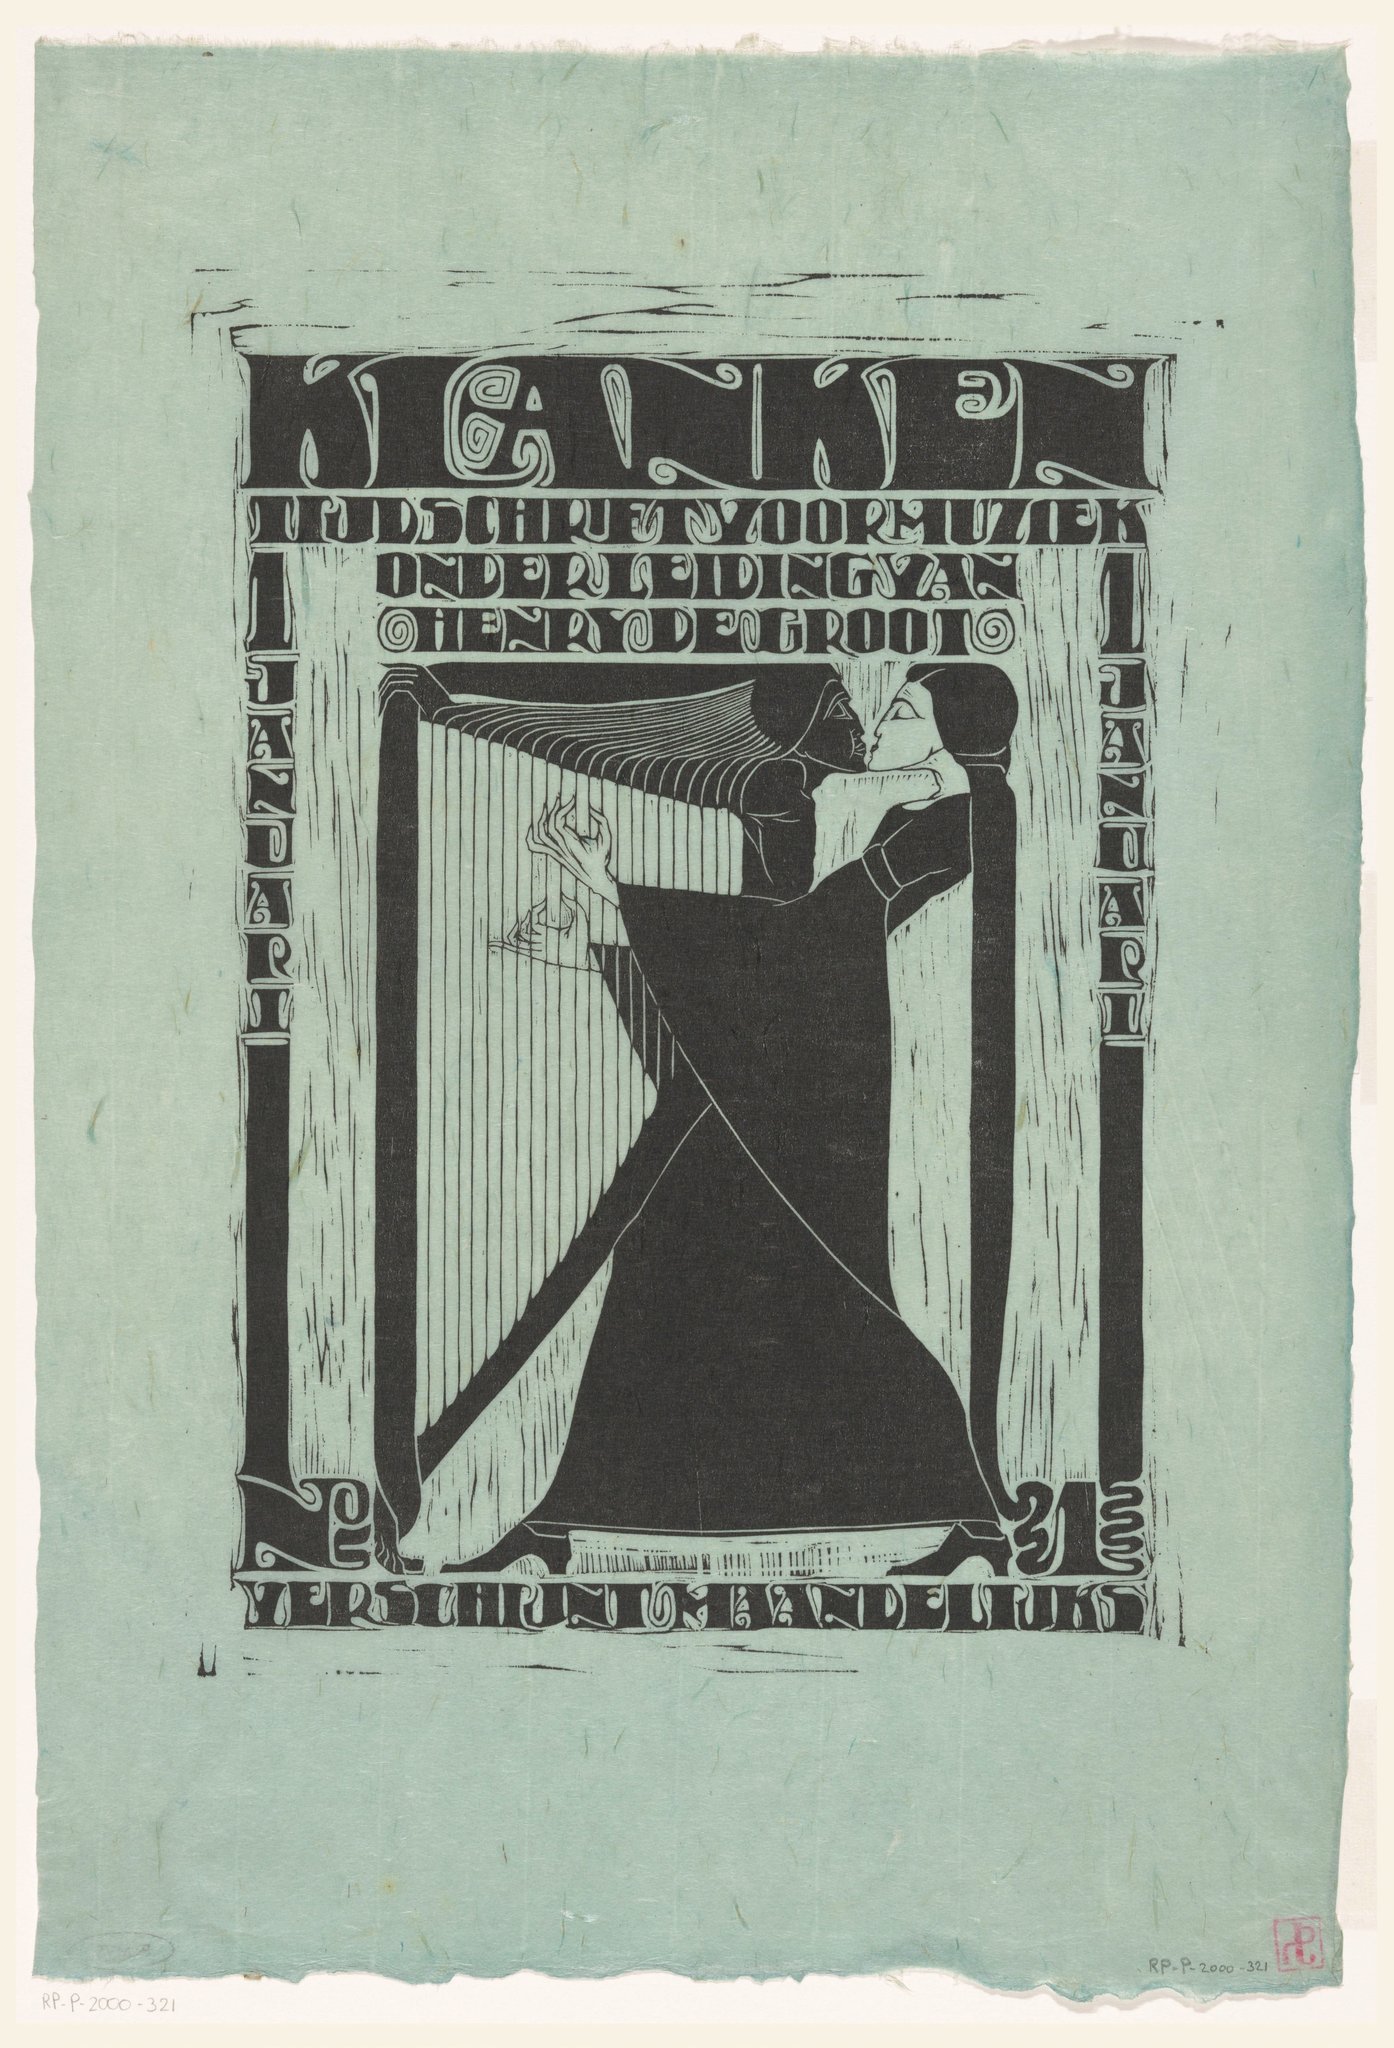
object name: print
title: Omslag tijdschrift Klanken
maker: chris lebeau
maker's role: draughtsman, print maker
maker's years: 1878-1945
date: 1888-1945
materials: paper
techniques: woodcut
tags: harp, one person playing string instrument (plucked)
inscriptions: collector's mark: Lugt 2228, collector's mark: ‘Ph. J.’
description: Omslag voor Klanken, tijdschrift voor muziek onder leiding van Henry de Groot. In het midden een harpspelende vrouw.